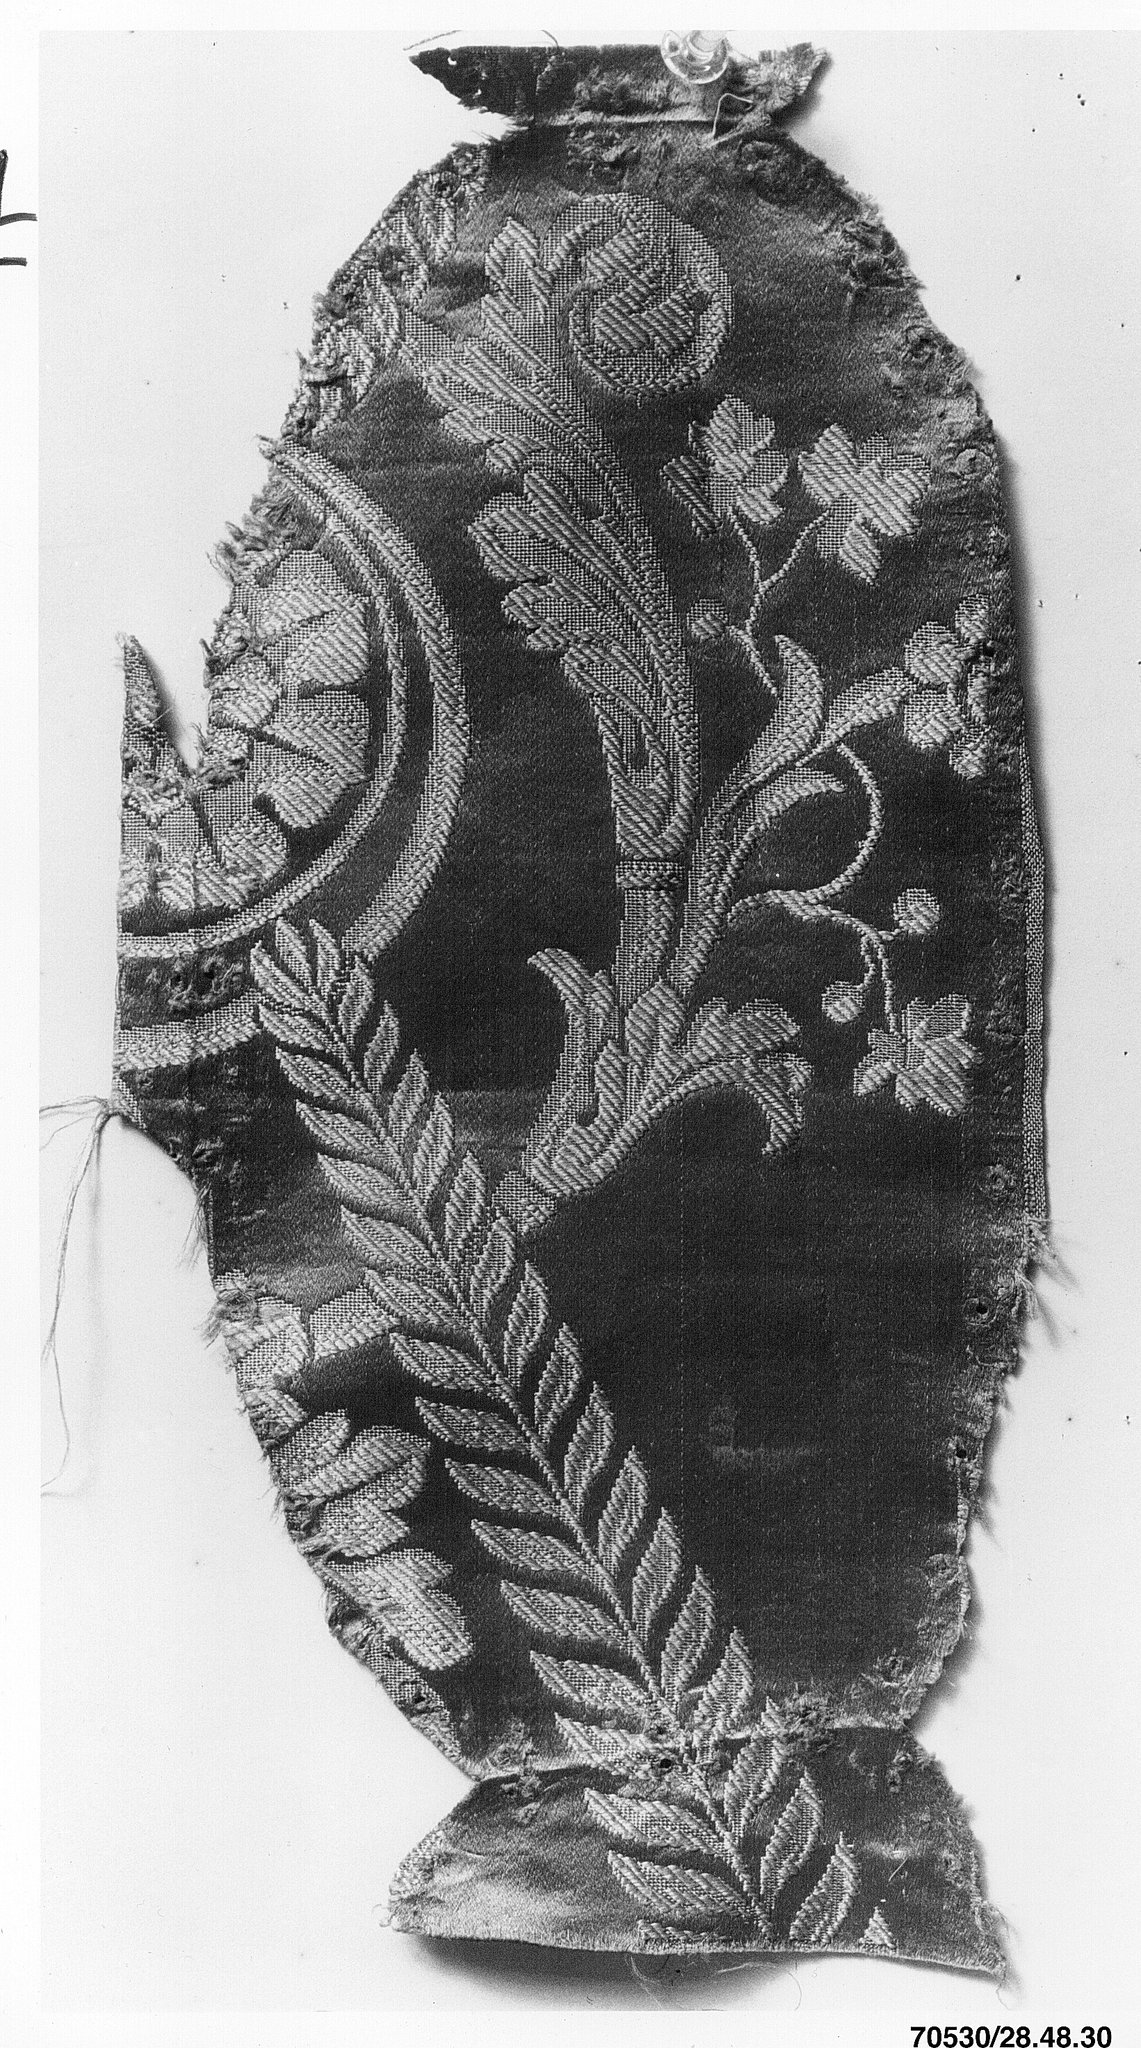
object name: piece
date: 1801-1900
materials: silk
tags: flowers,leaves